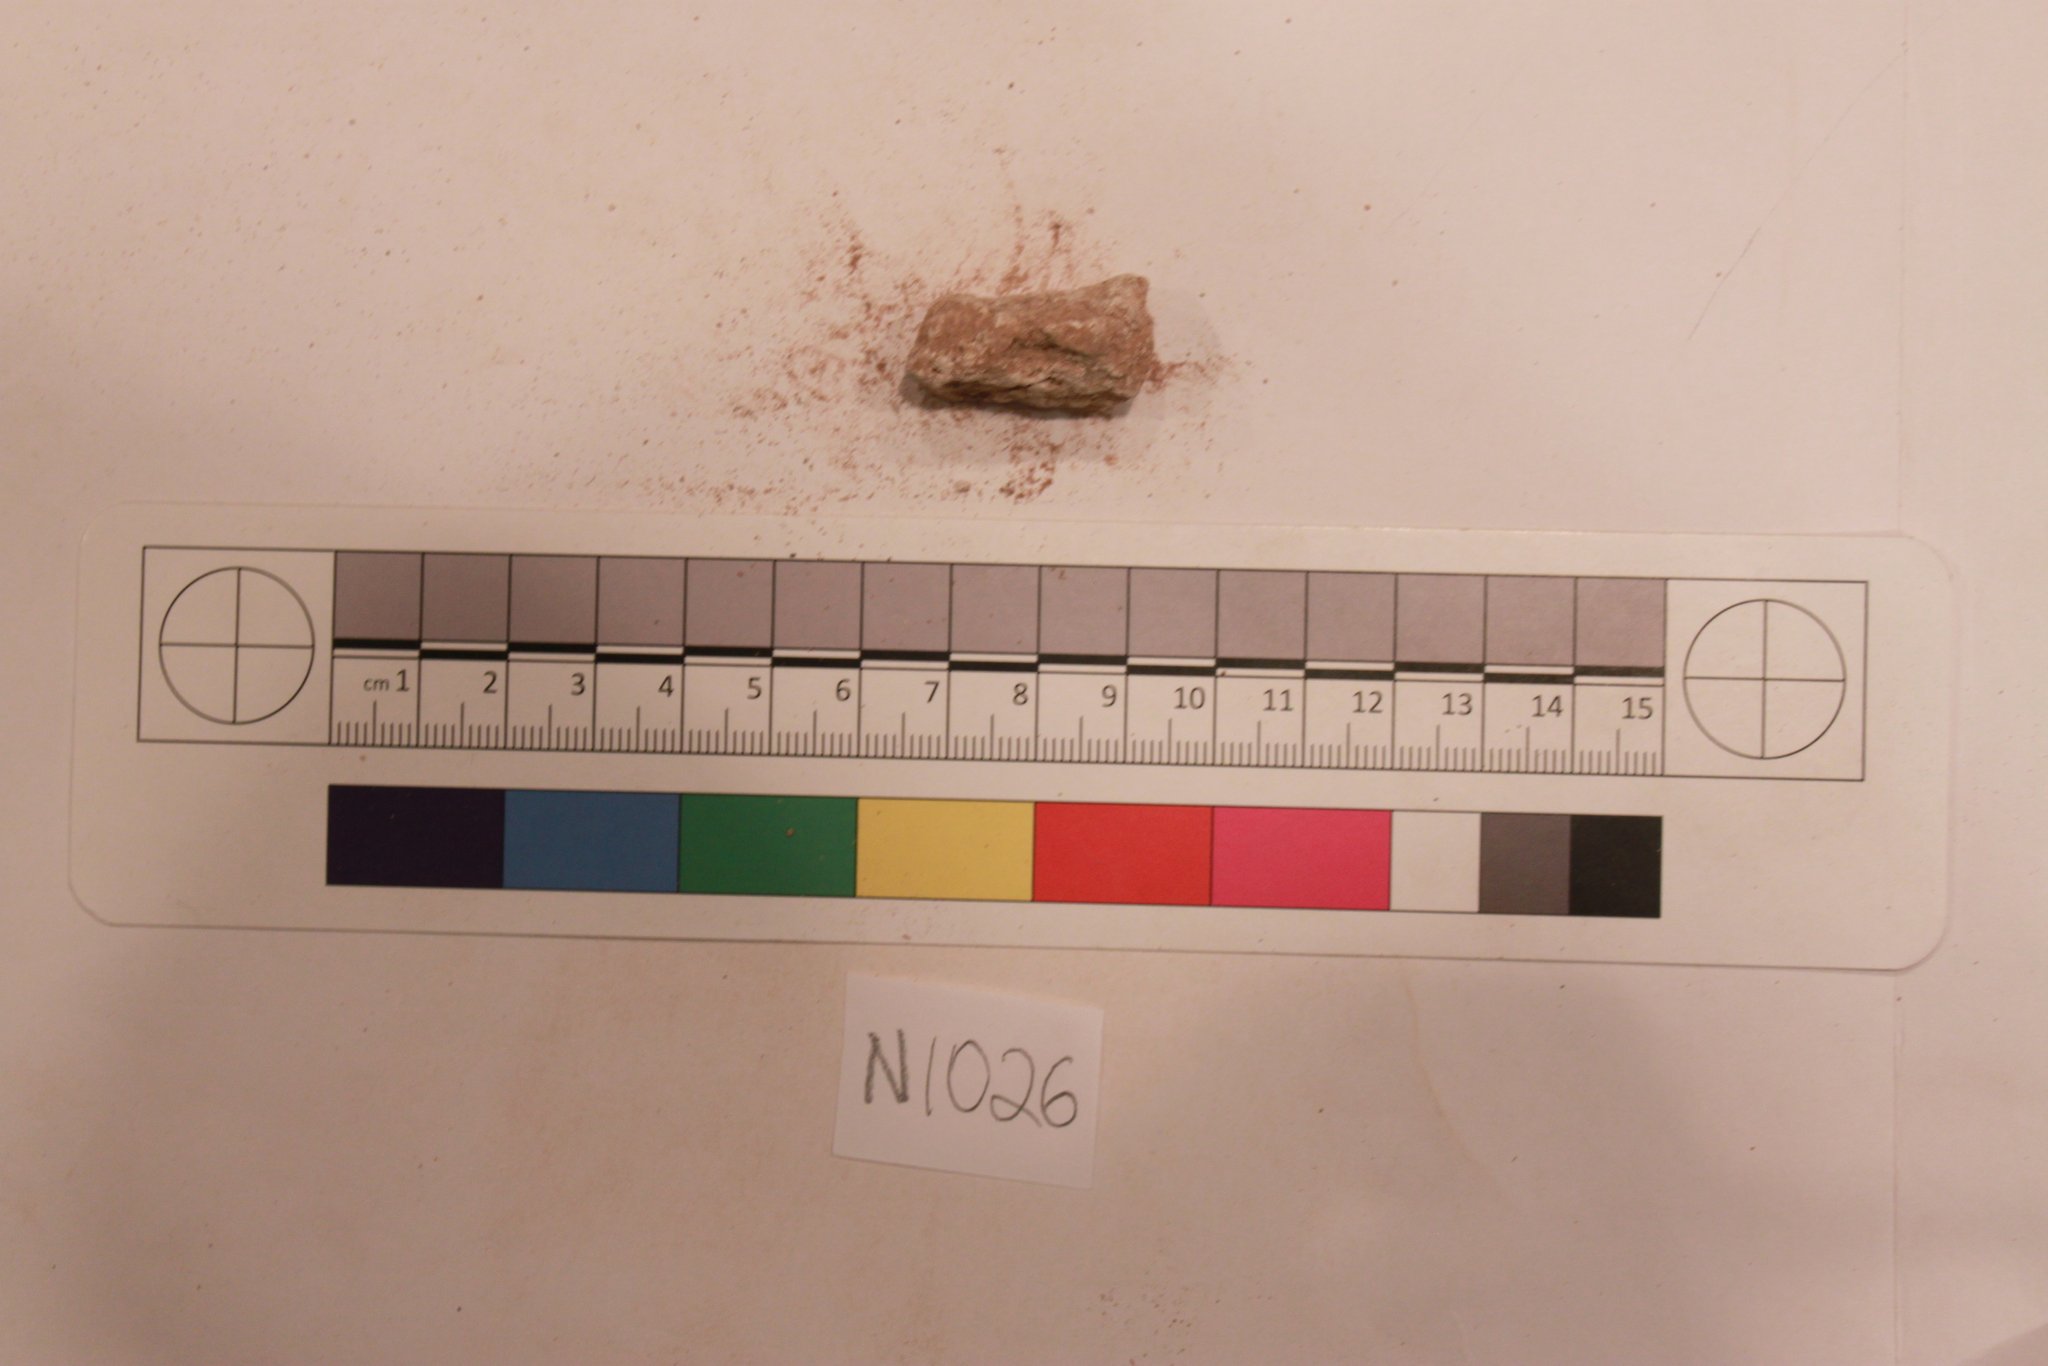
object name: fragment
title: Stucco Fragment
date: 701-1200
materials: plaster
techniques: carving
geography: iran